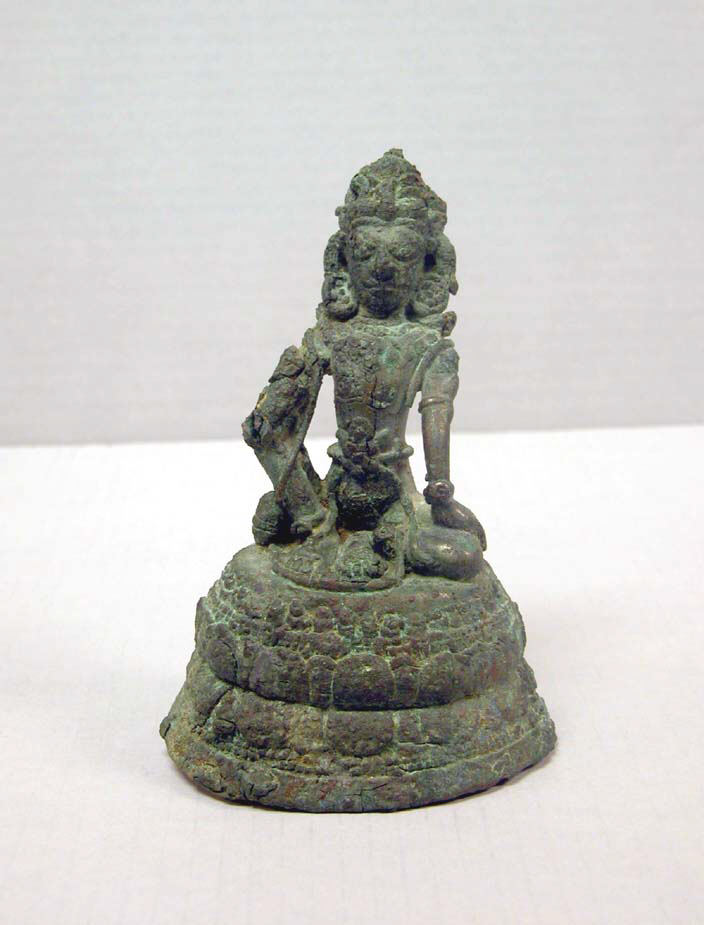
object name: figure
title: Seated Maitreya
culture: burmese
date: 701-900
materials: bronze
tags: buddhism,bodhisattvas,maitreya